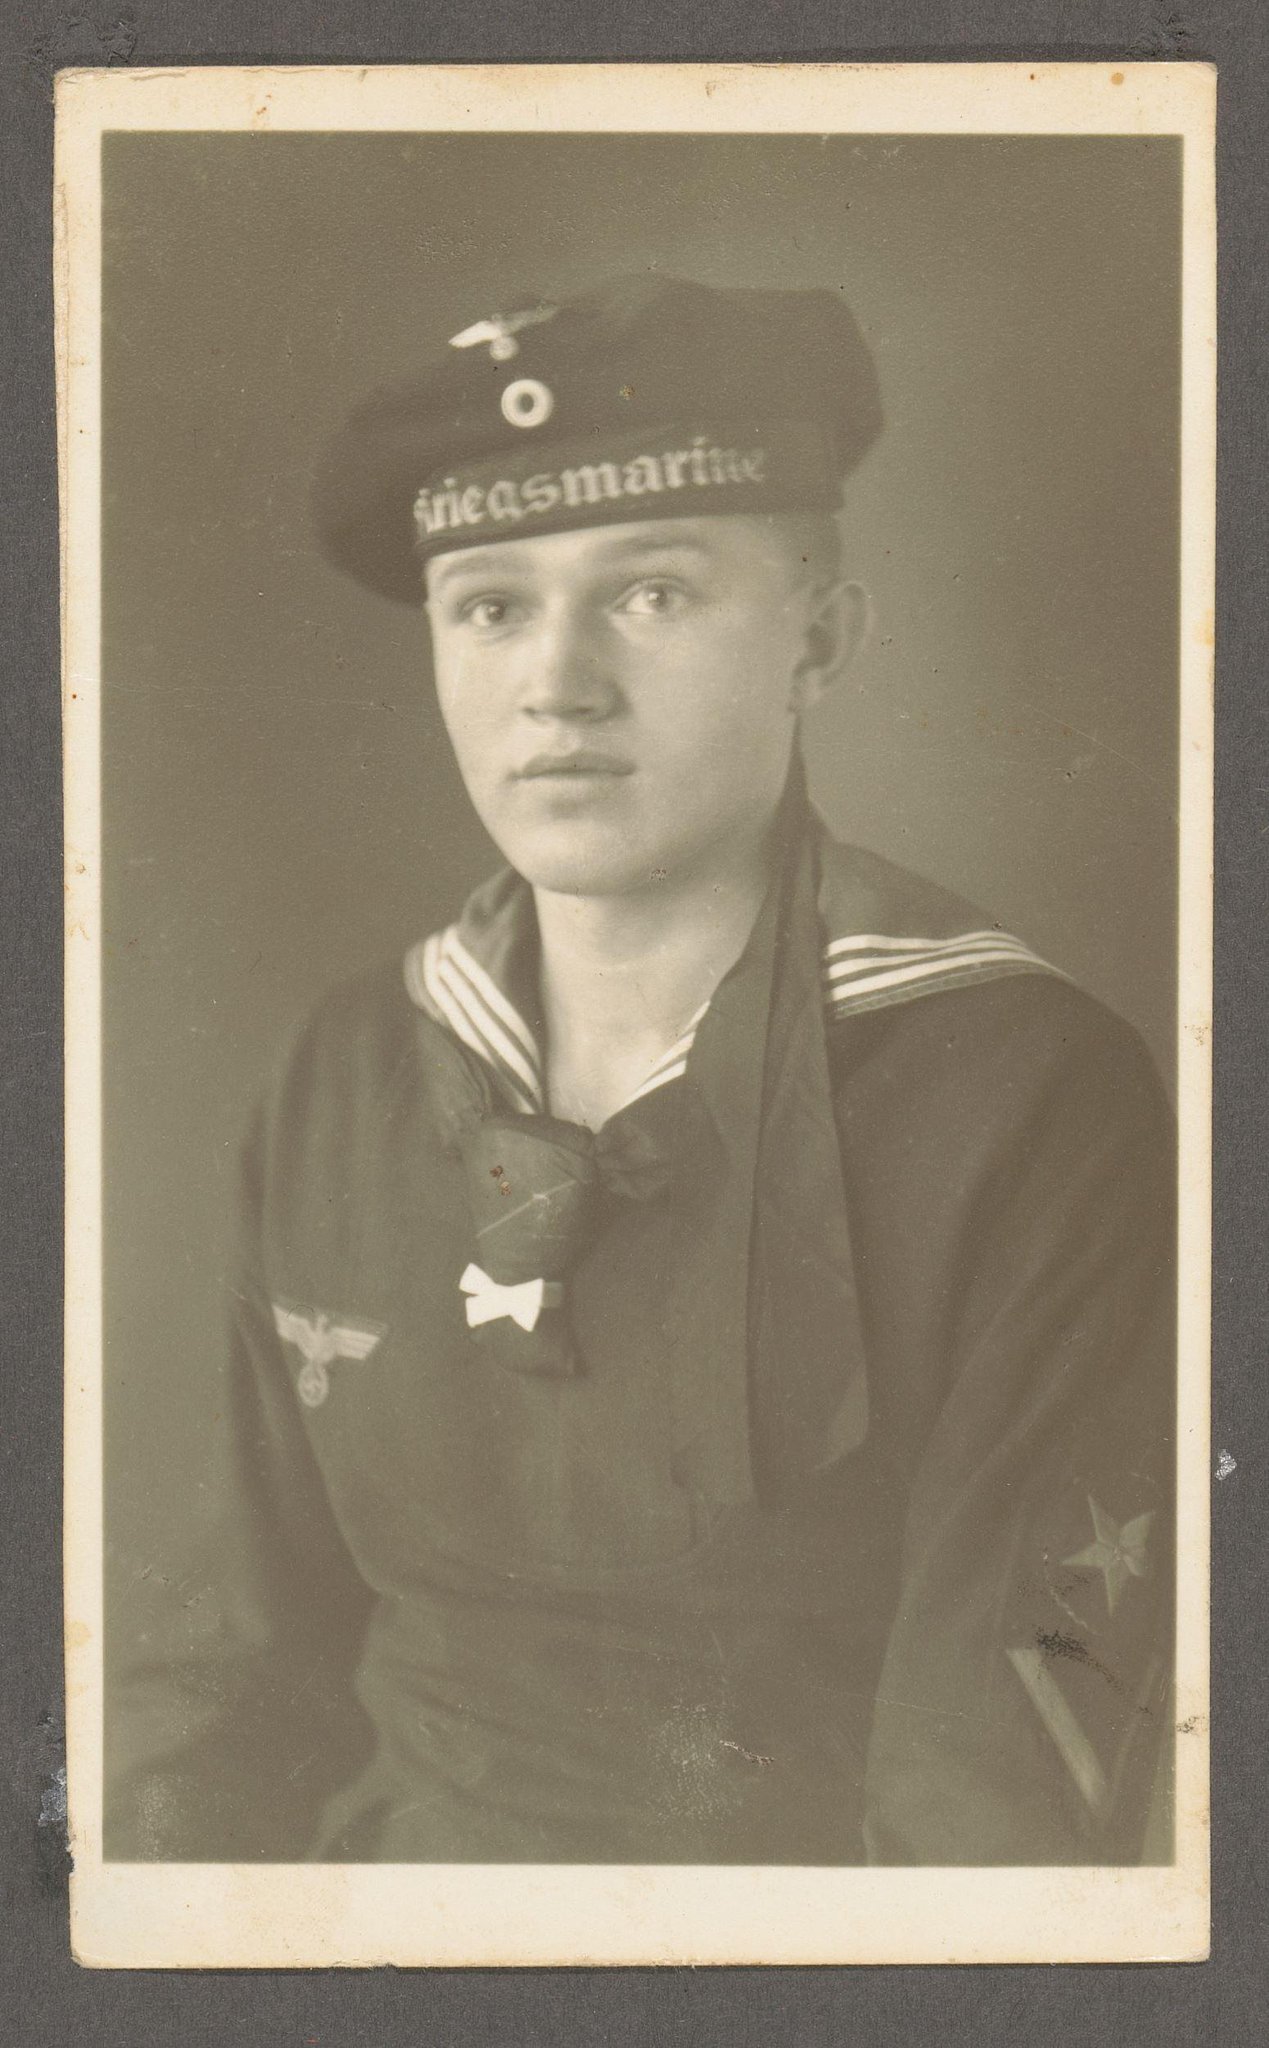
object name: photograph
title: Portret van een militair in uniform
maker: Anonymous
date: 1941-1945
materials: paper, photographic support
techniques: gelatin silver print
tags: adult man, historical persons, the soldier; the soldier's life, (military) uniforms